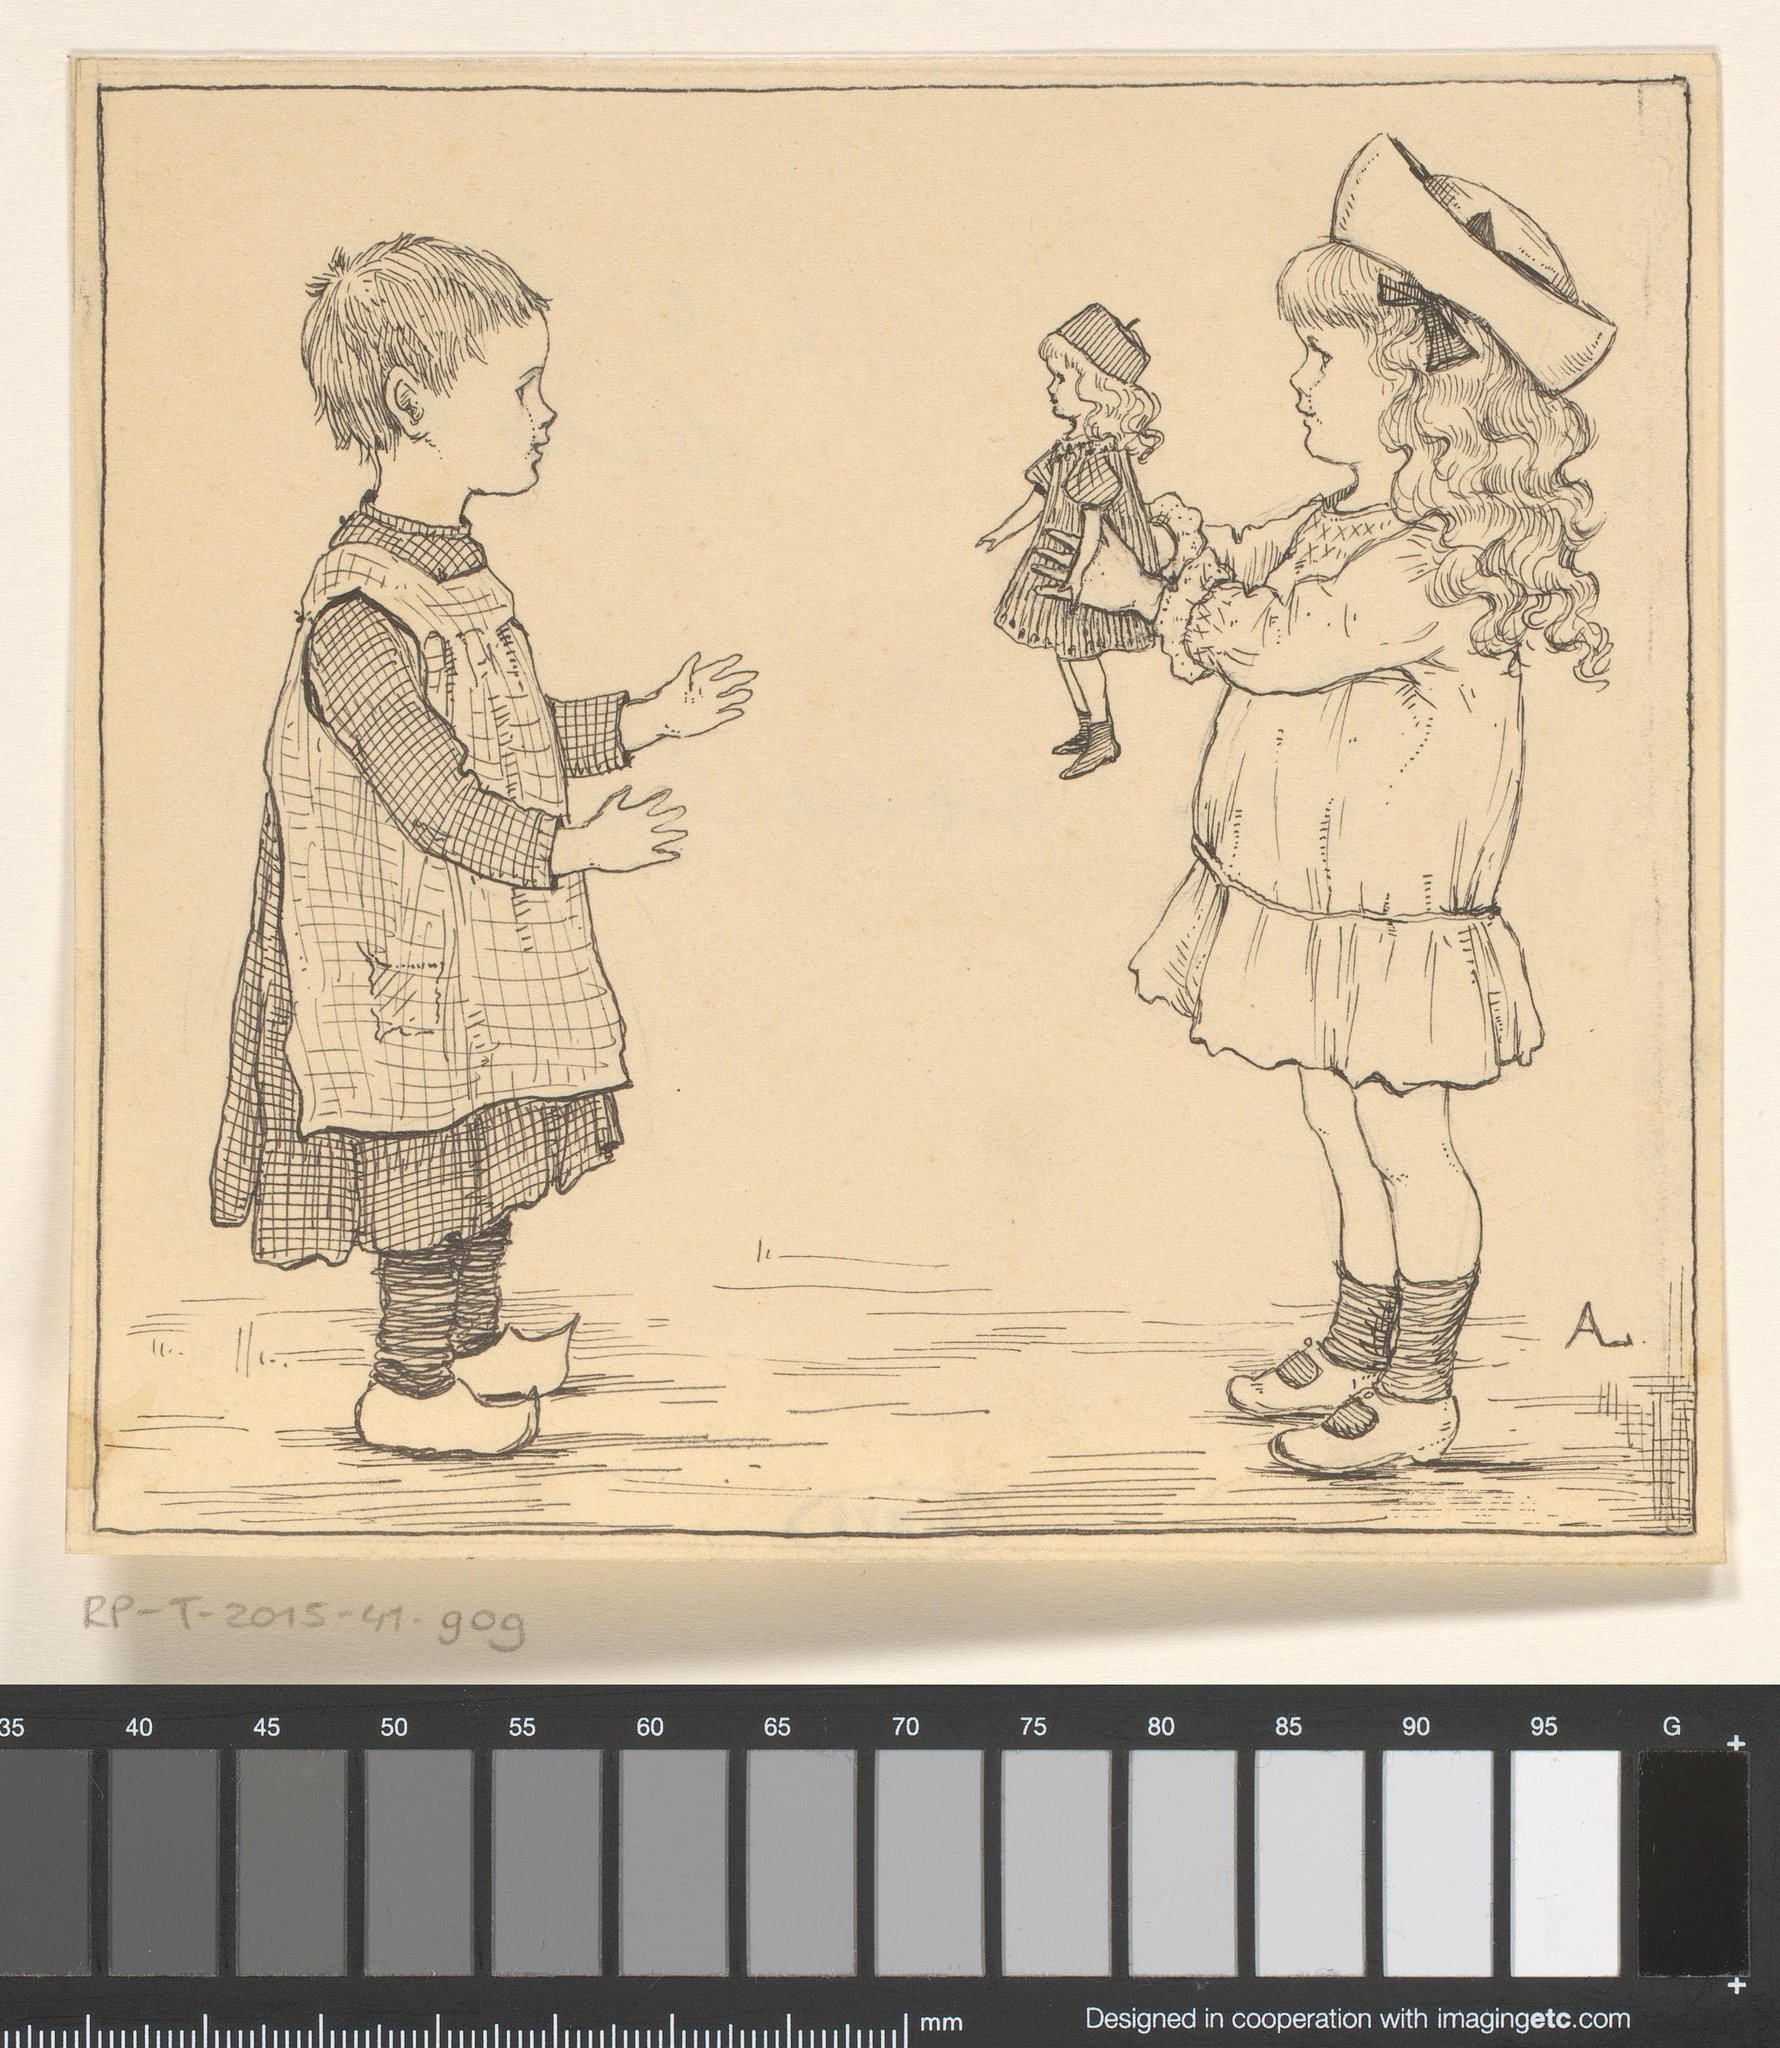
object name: boekillustratie ontwerp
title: Meisje geeft een pop aan een meisje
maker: adri ladenius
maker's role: draughtsman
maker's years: 1883-1953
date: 1893-1953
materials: ink, paper, pencil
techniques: pen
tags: girl (child between toddler and youth), (playing with) dolls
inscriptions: collector's mark: Lugt 2228, monogram: ‘AL’, :, annotation: ‘Een advertentie’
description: Een meisje met lang krullend haar en een hoed houdt een pop omhoog voor een meisje met kortgeknipte haren en een eenvoudige jurk met schort.